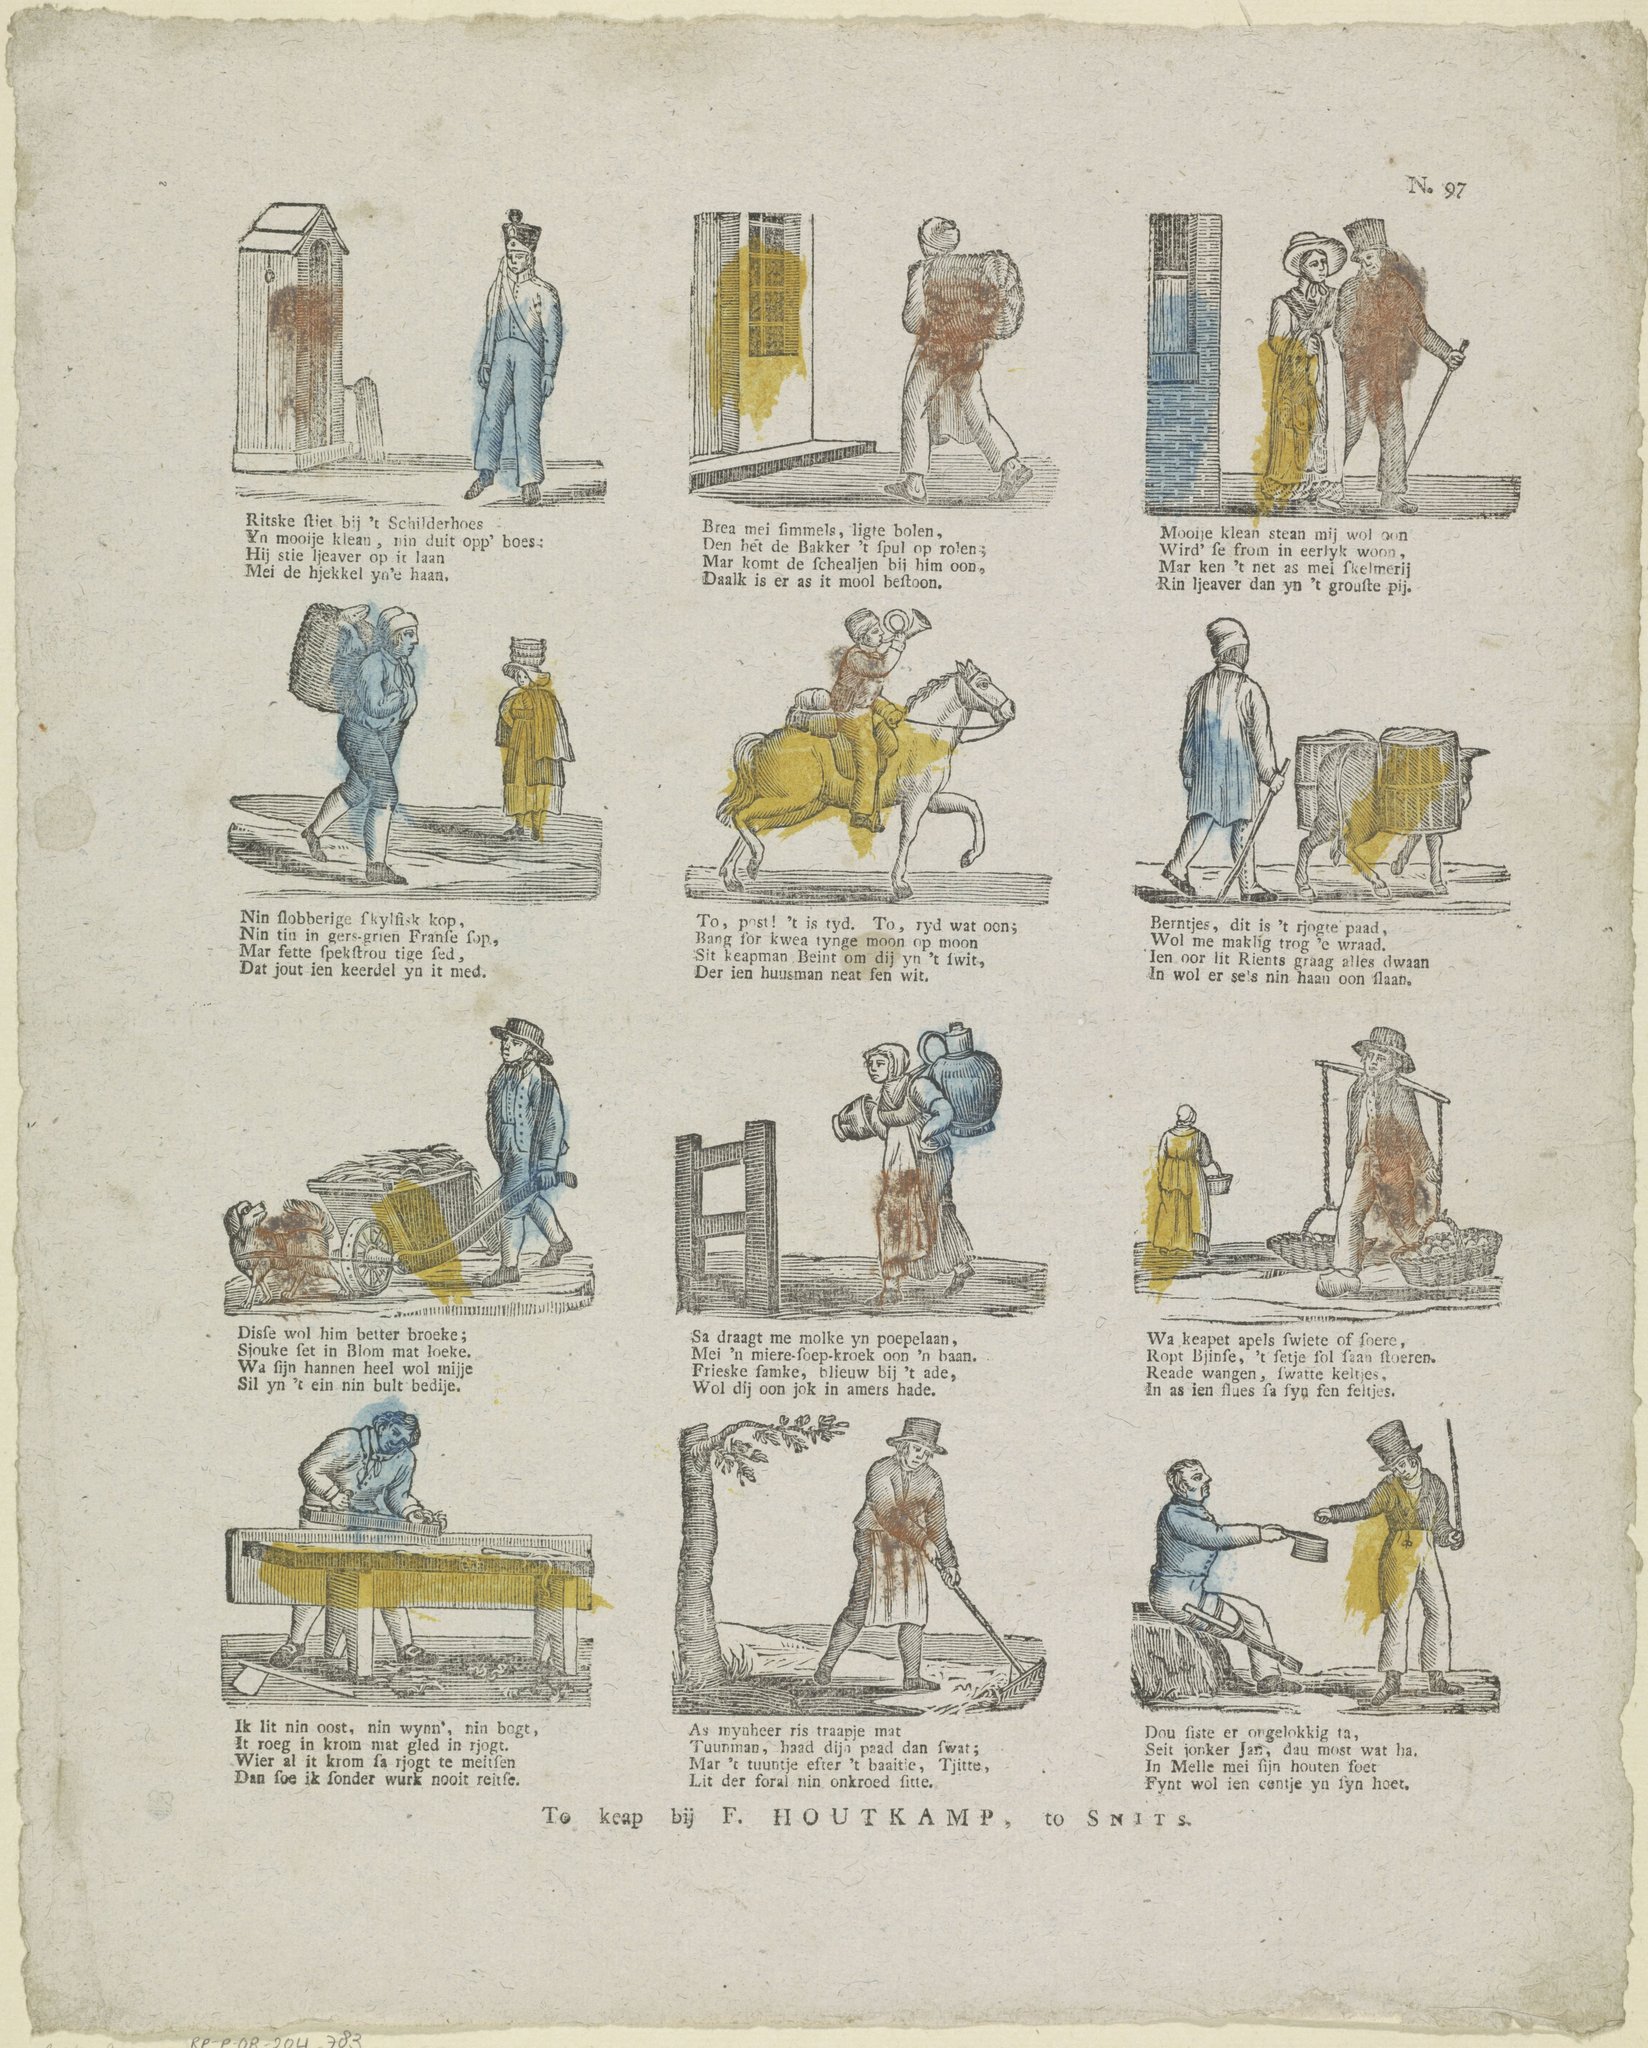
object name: popular print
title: Beroepen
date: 1822-1849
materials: paper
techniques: colour, letterpress printing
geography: netherlands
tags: craft-production, skilled handiwork, street-trader, baker, crafts and industries, guard duty, keeping sentry, merchant, salesman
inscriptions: collector's mark: Lugt 2760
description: Blad met 12 voorstellingen van ambachtslieden en beroepen, zoals schildwacht, bakker en tuinman. Onder elke afbeelding een vierregelig vers in het Fries. Genummerd rechtsboven: N. 97.